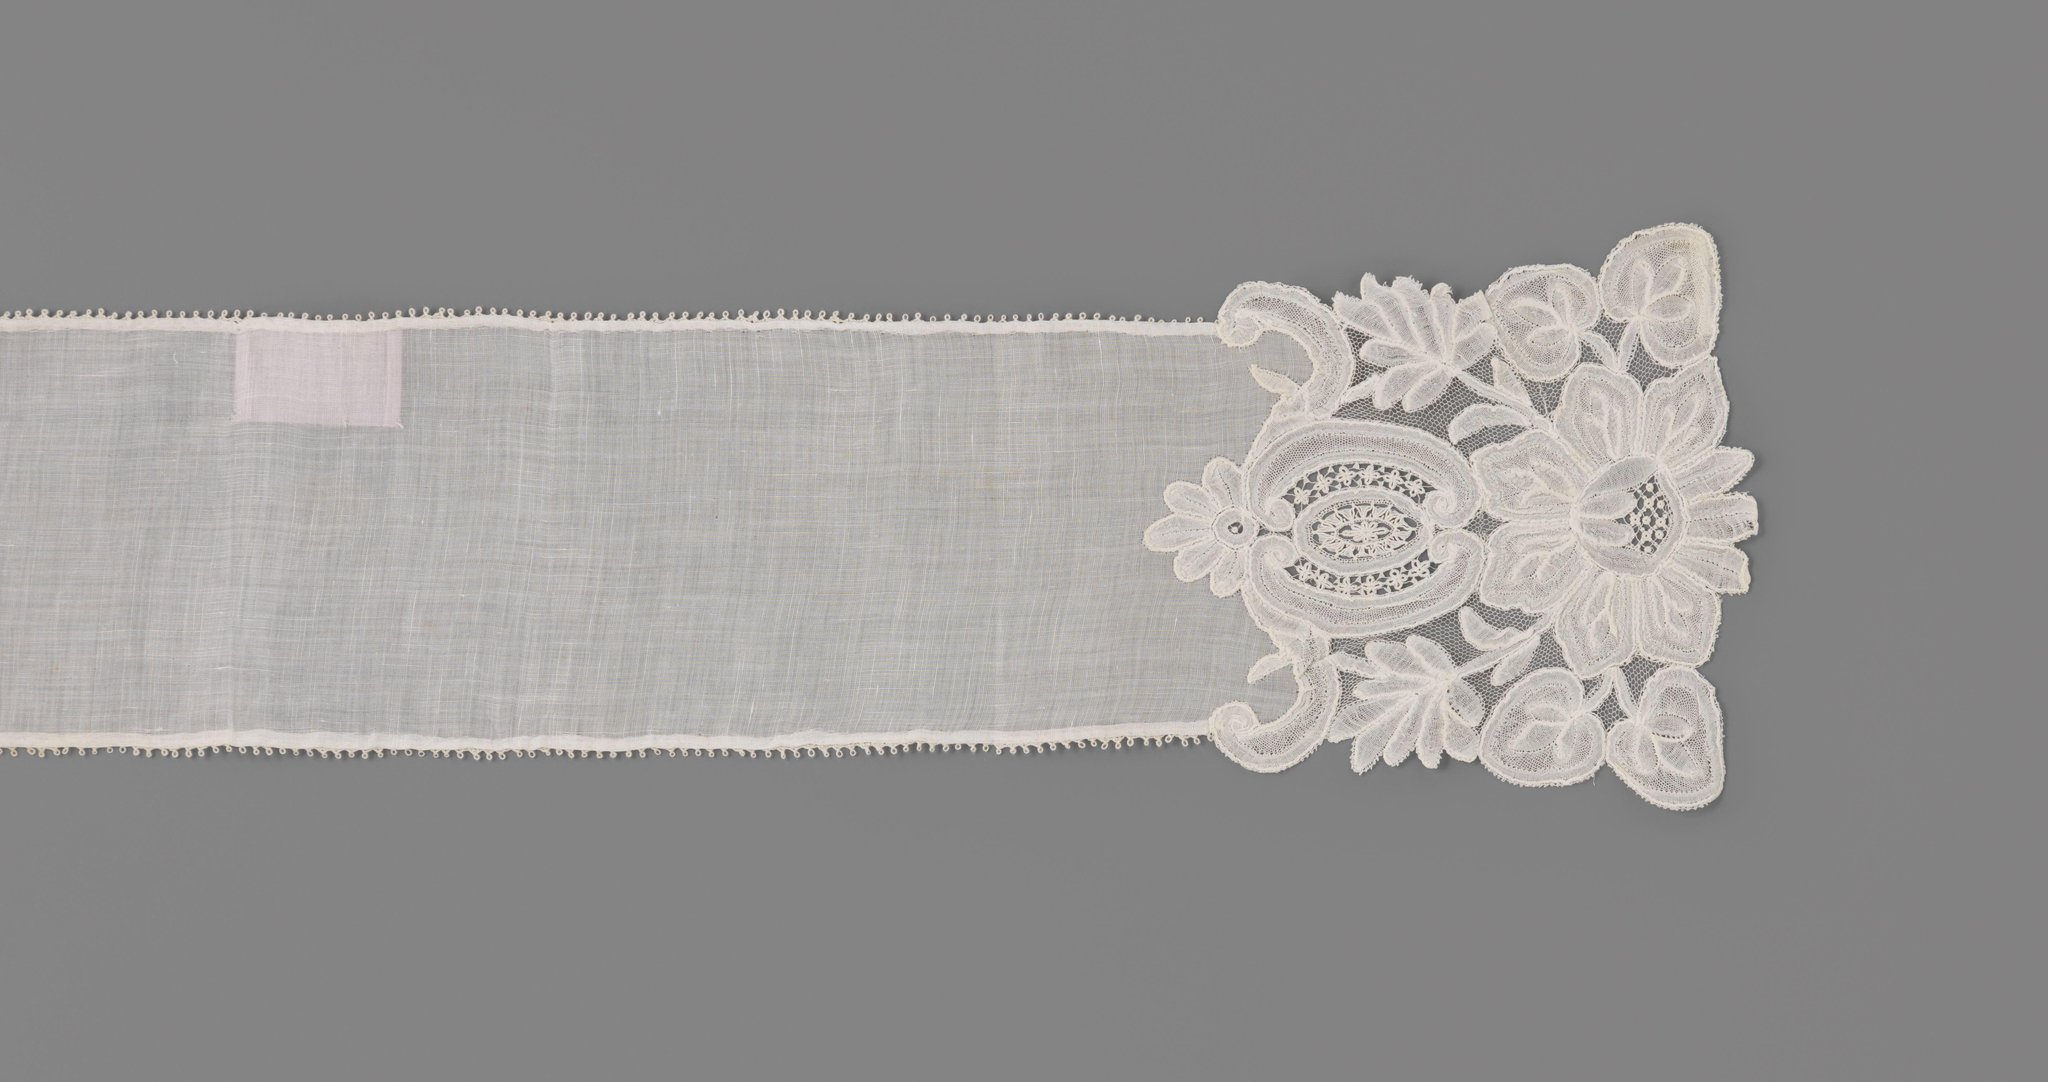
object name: neckcloth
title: Das van linnenbatist met uiteindenen van Duchesse kant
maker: Anonymous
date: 1890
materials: linen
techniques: lace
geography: belgium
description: Das van linnenbatist met uiteindenen van Duchesse kant. De randen zijn voorzien van picots. Het onregelmatig geschulpte kantpatroon bestaat uit een medaillon gevormd door twee c-vormige voluten bekroond door een palmet met daaronder een bloem tussen zes bladeren.